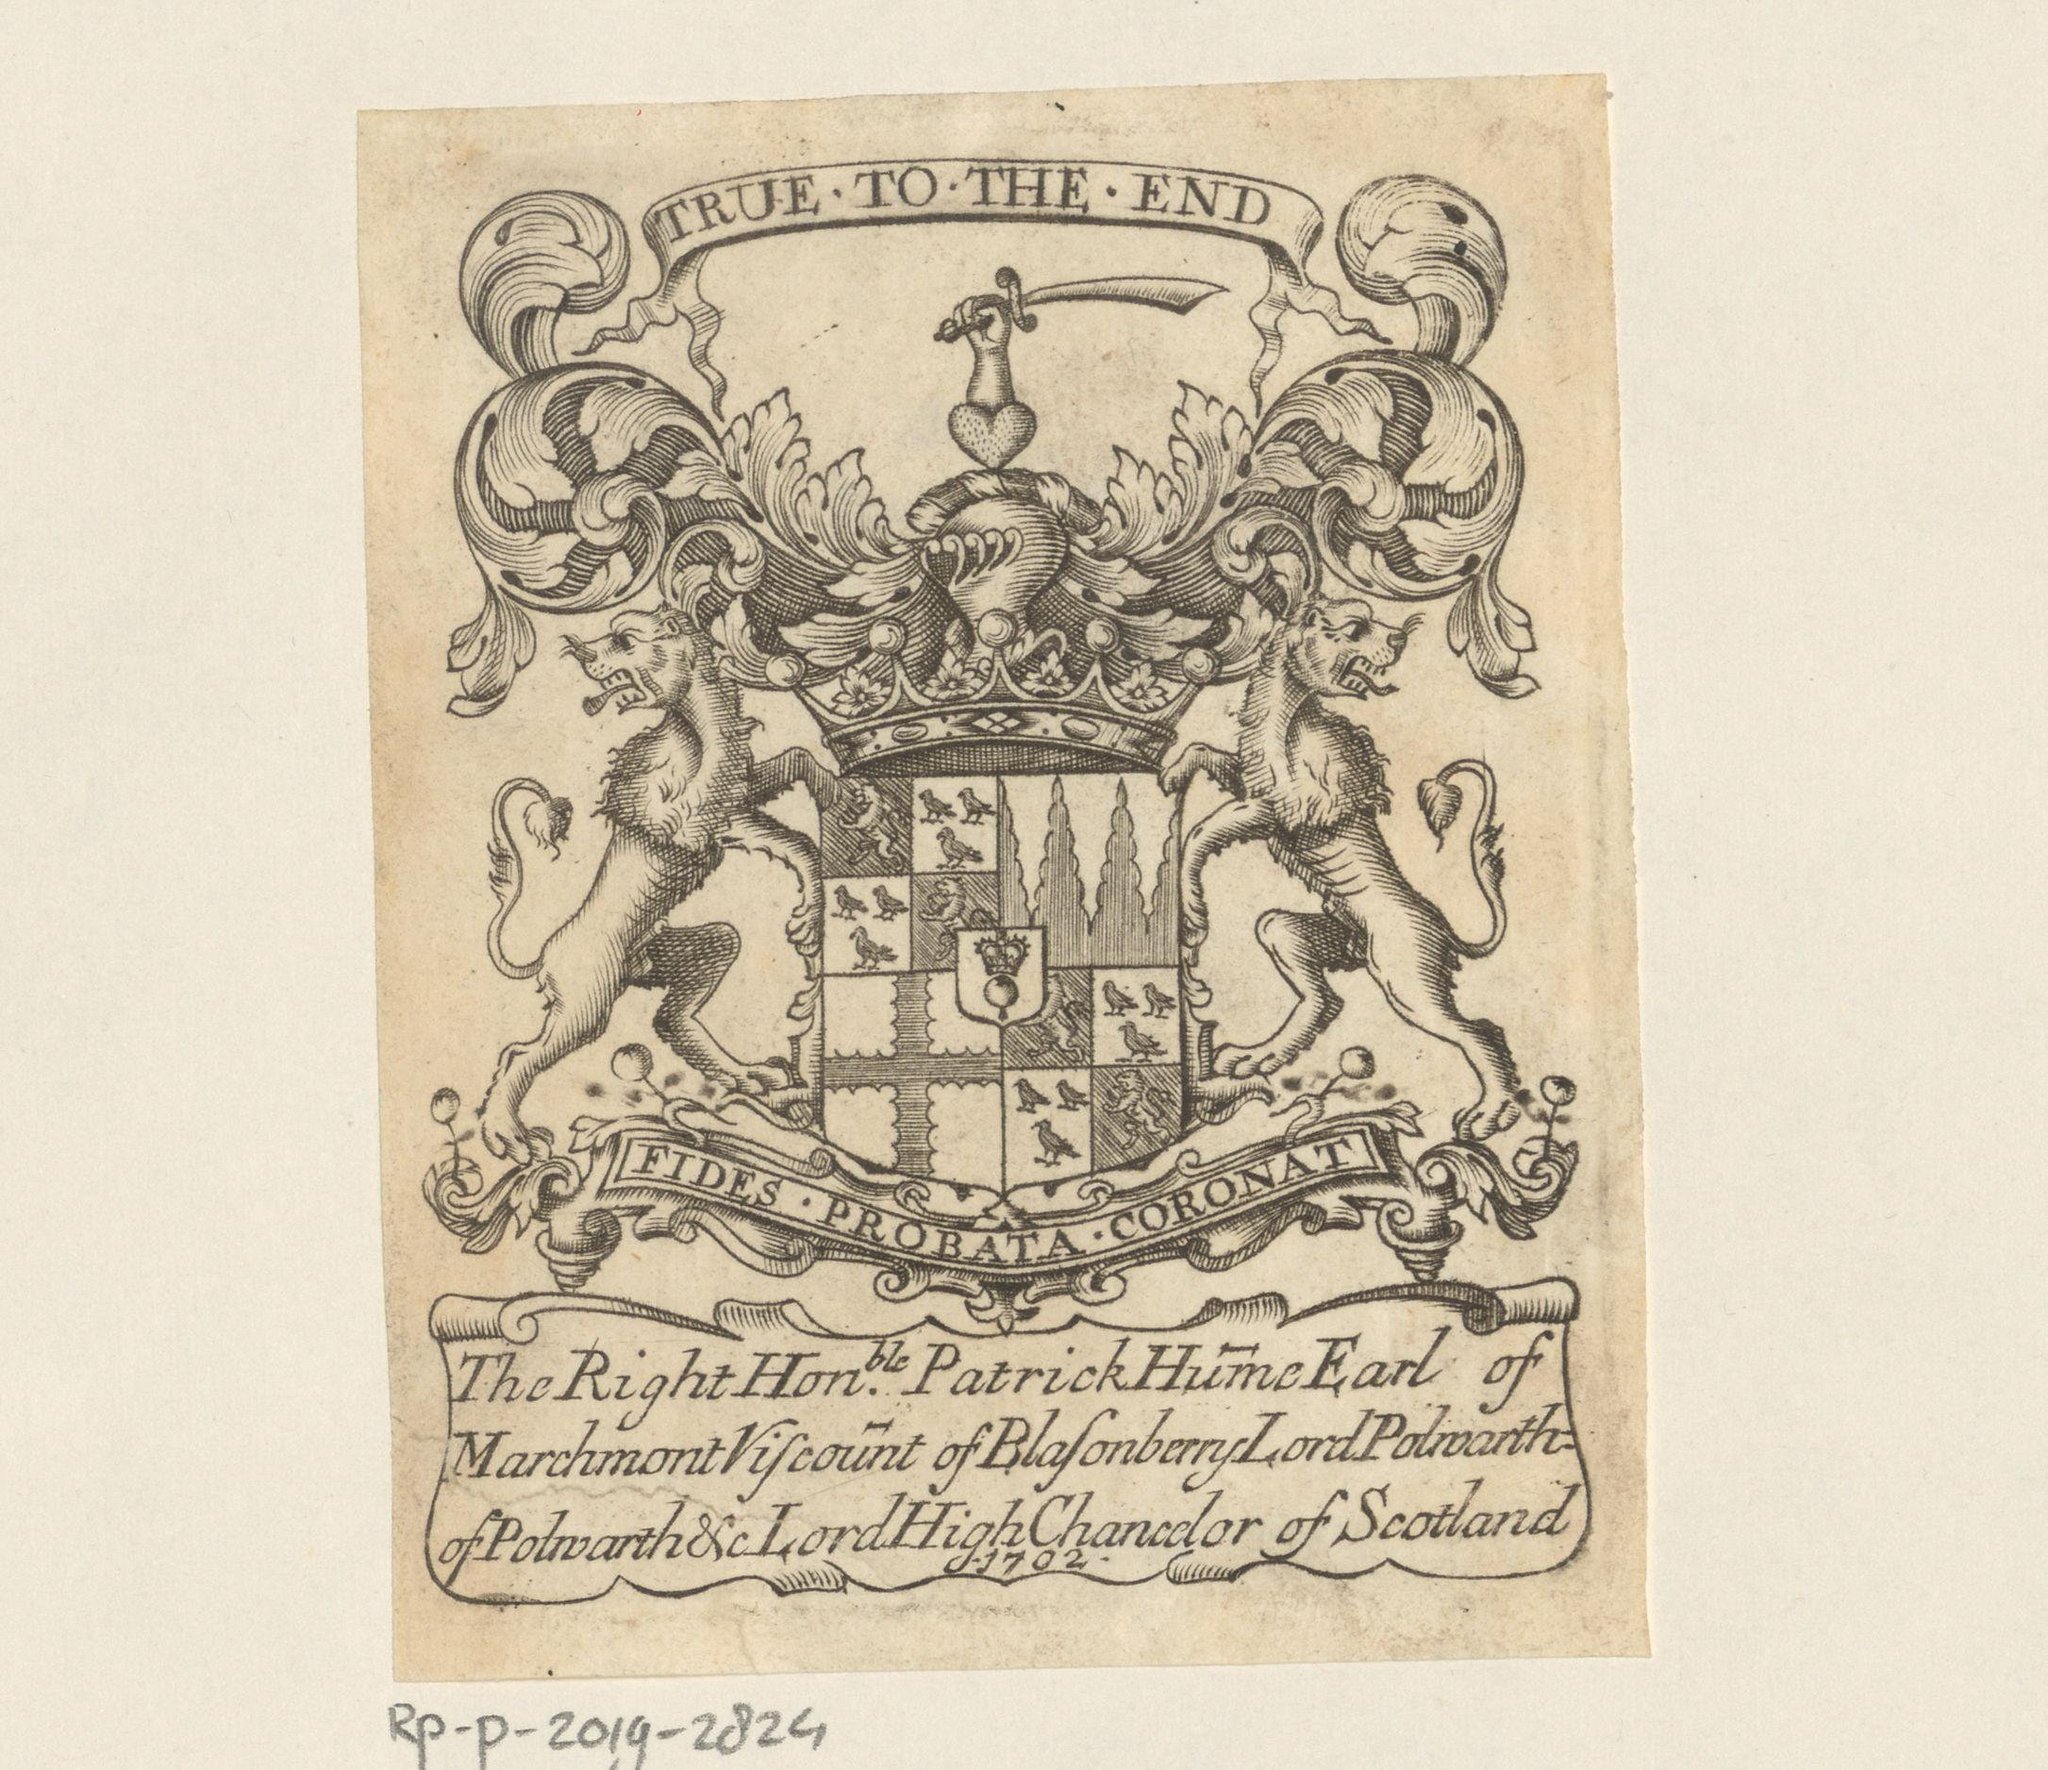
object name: bookplate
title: True to the end / Fides probata coronat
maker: Anonymous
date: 1702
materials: paper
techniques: engraving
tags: politician, armorial bearing, heraldry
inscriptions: date